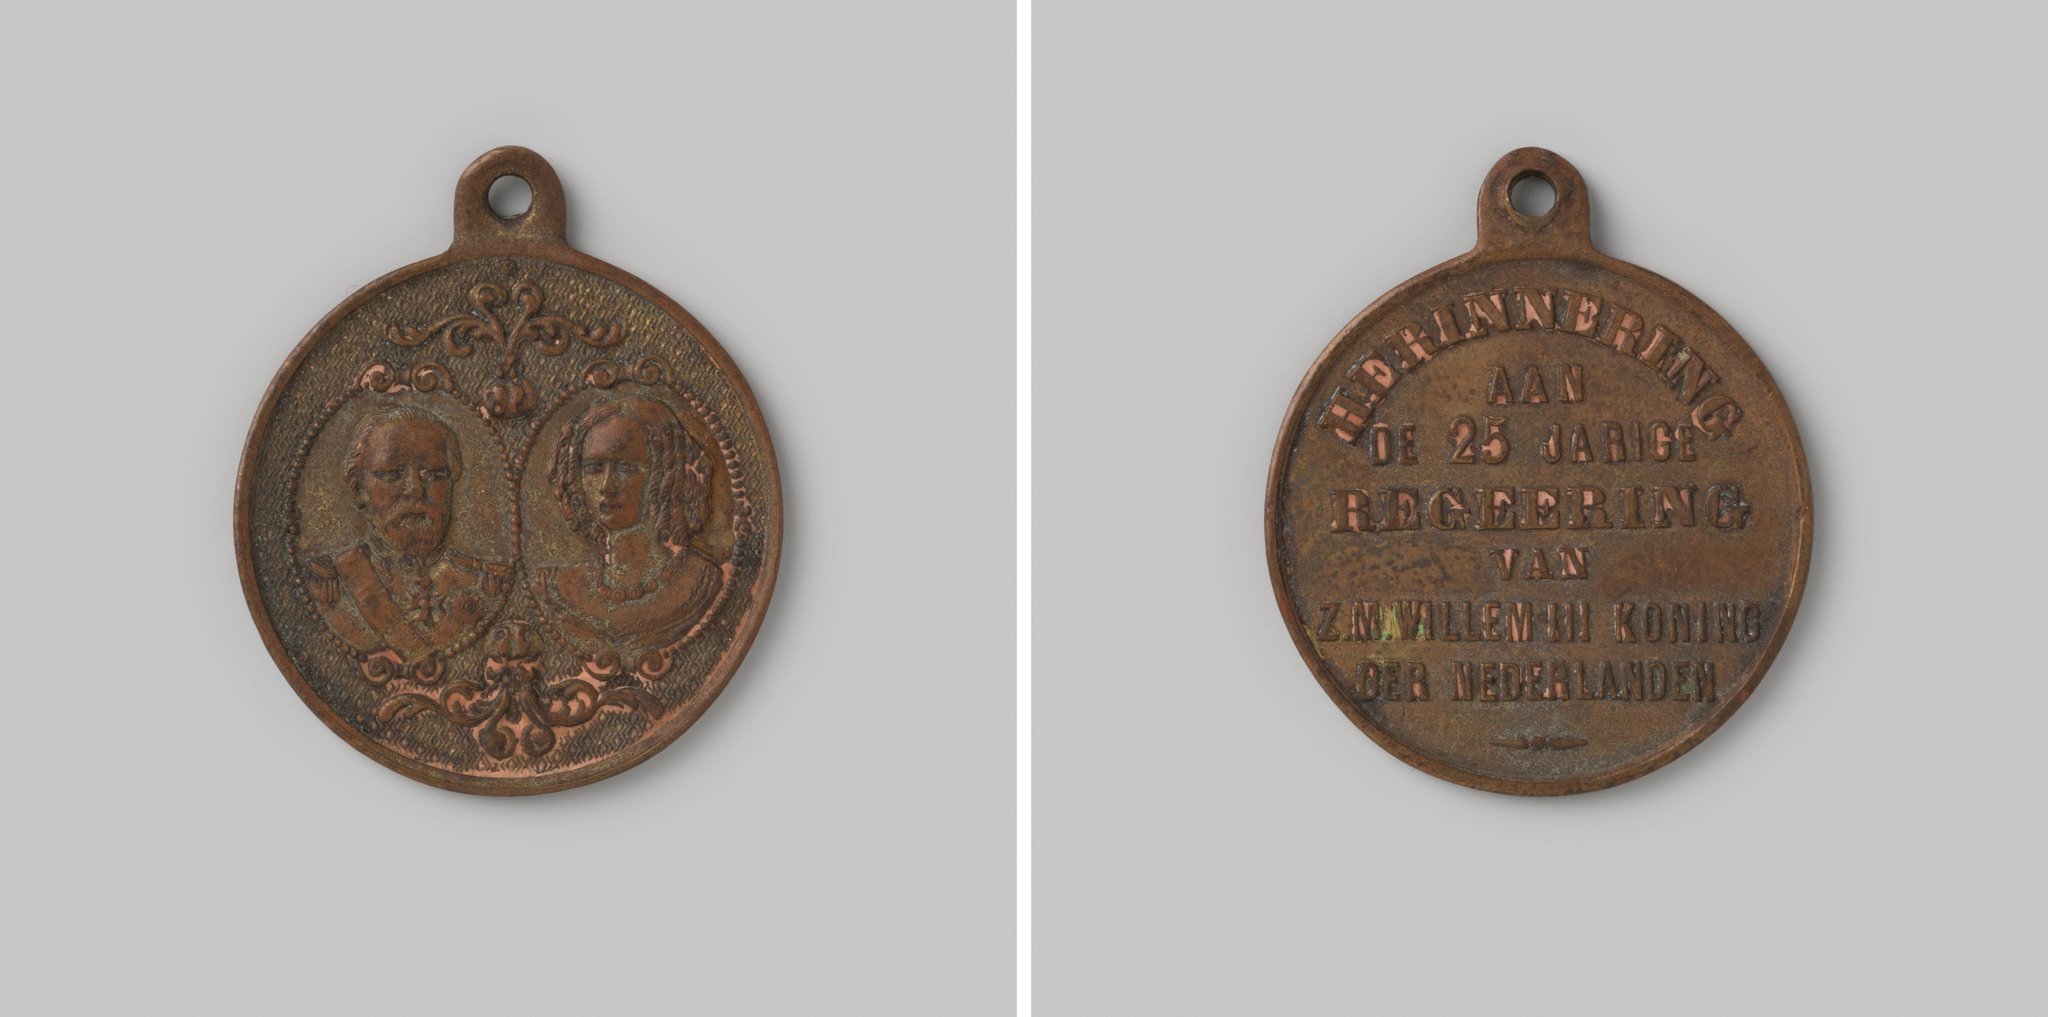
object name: history medal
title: Vijfentwintigjarig regeringsjubileum van Koning Willem III en Koningin Sophia 1874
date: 1874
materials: brass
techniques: striking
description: Messing penning met draagoog, op de voorzijde twee ovale medaillons met de aanziende portretten van Willem III en Sophia, waarbuiten een gematteerd veld met bladornamenten, op de keerzijde zeven regels tekst.